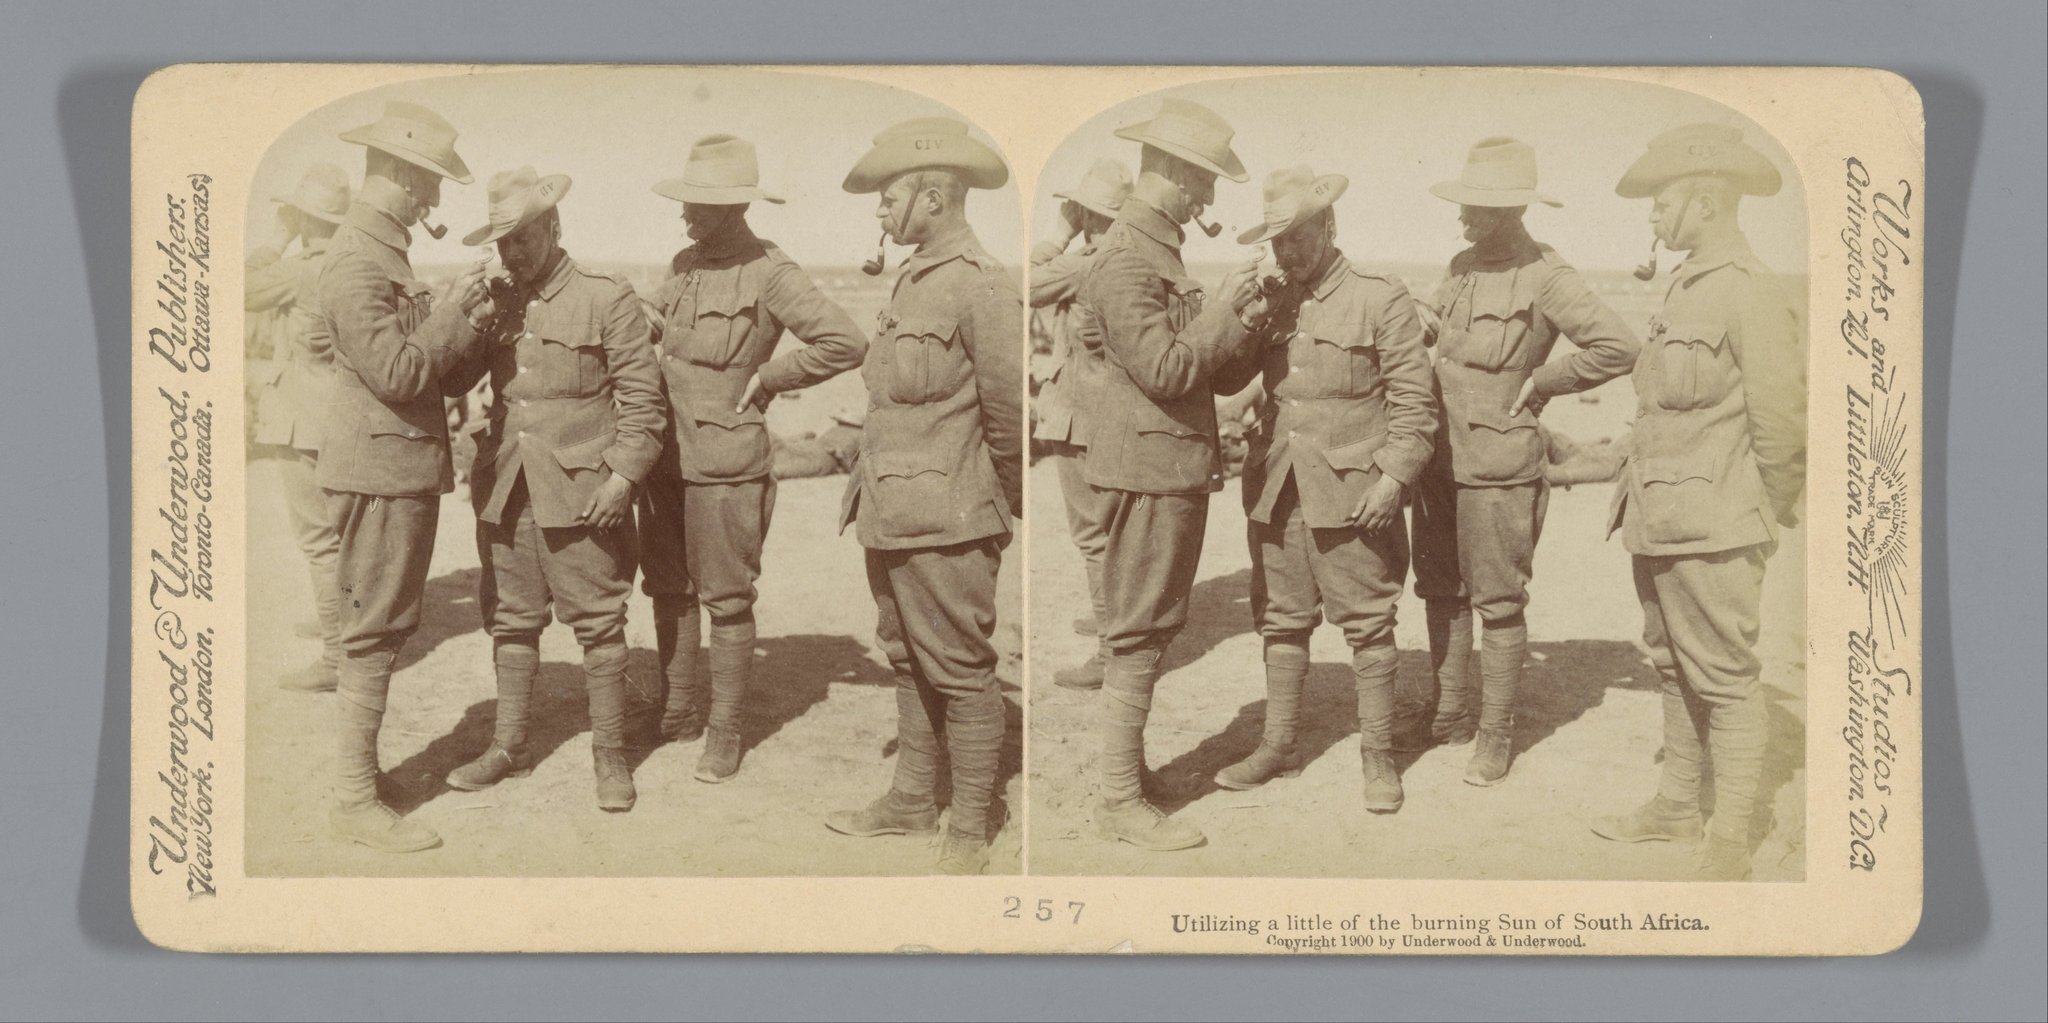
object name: stereograph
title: Utilizing a little of the burning Sun of South Africa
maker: Anonymous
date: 1900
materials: cardboard, paper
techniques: albumen print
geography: new york city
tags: pipe ~ tobacco, officer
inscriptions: number: ‘257’, inscription, inscription: ‘Works and Studios ~/ Arlington, N.J. Littleton, N.H. Washington, D.C.’, copyright notice: ‘Copyright 1900 by Underwood & Underwood.’